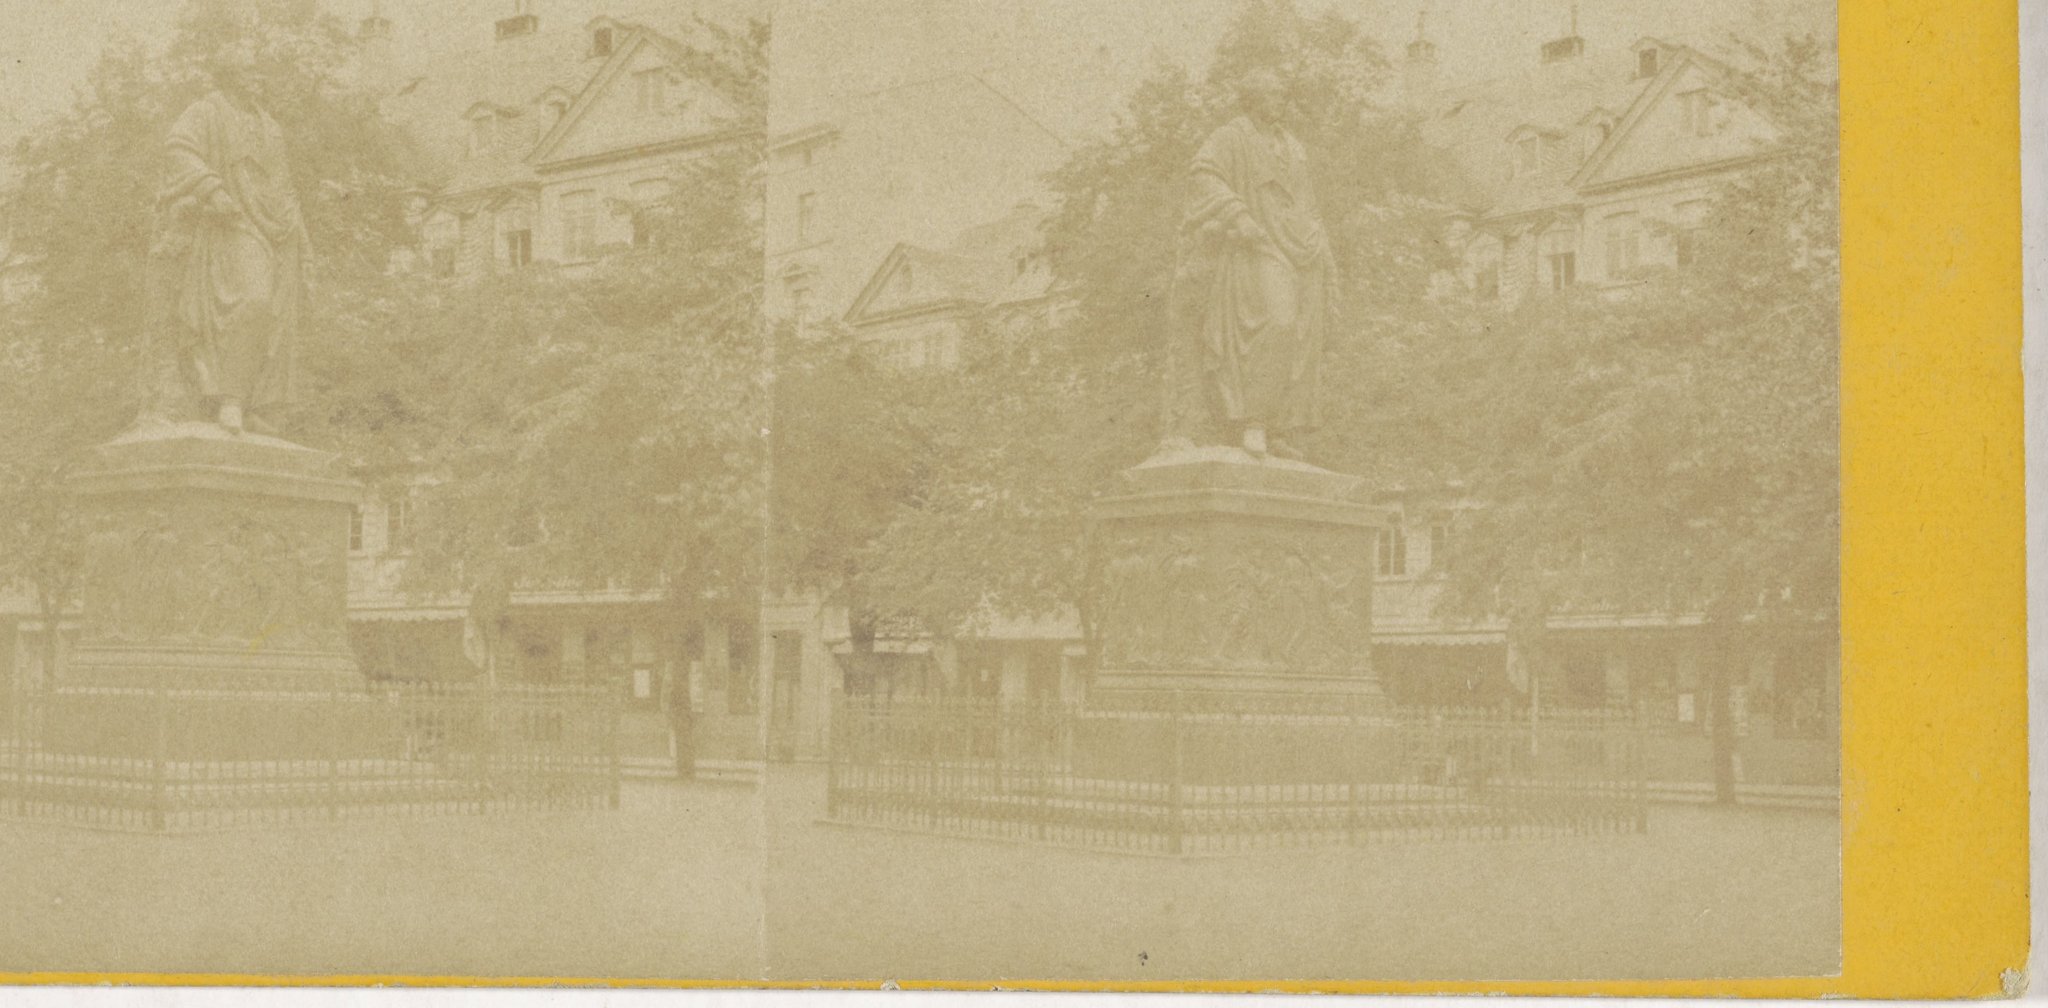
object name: stereograph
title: Allemagne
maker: hippolyte jouvin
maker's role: fotograaf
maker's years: 1825-1889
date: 1860-1865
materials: cardboard, paper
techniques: albumen print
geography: frankfurt am main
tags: draughtsman, johann wolfgang von goethe, square, place, circus, etc., monument, statue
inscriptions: number: ‘N. 398’, inscription: ‘U’, inscription: ‘H/ 40’, inscription: ‘Déposé.’